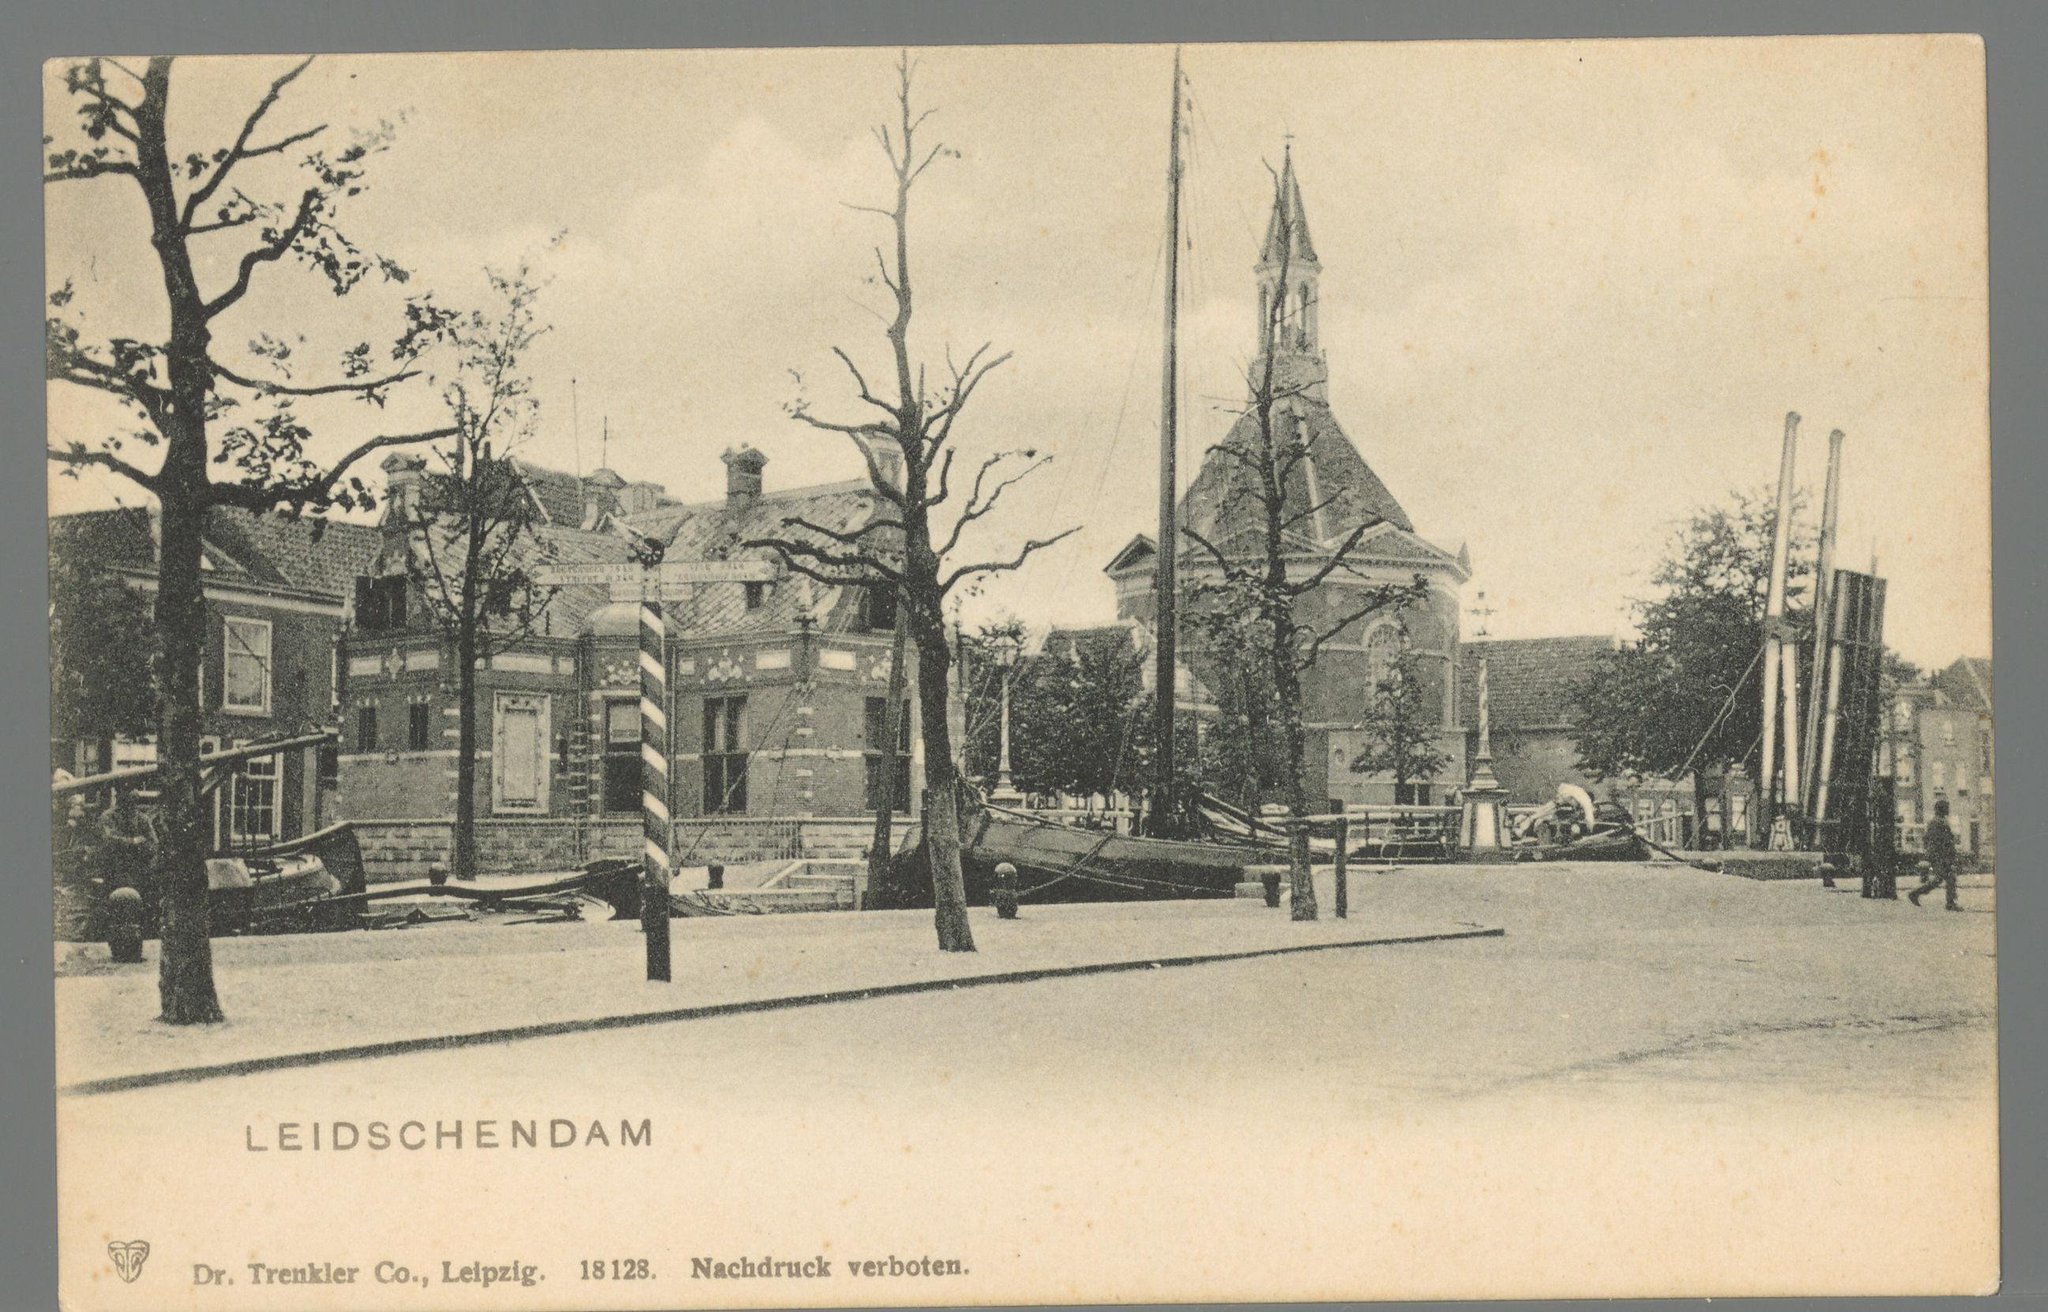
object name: ansichtkaart, prentbriefkaart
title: Leidschendam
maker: Anonymous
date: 1897-1905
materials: cardboard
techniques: photograph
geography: leipzig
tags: sluice, weir, city-view, and landscape with man-made constructions, river, church (exterior)